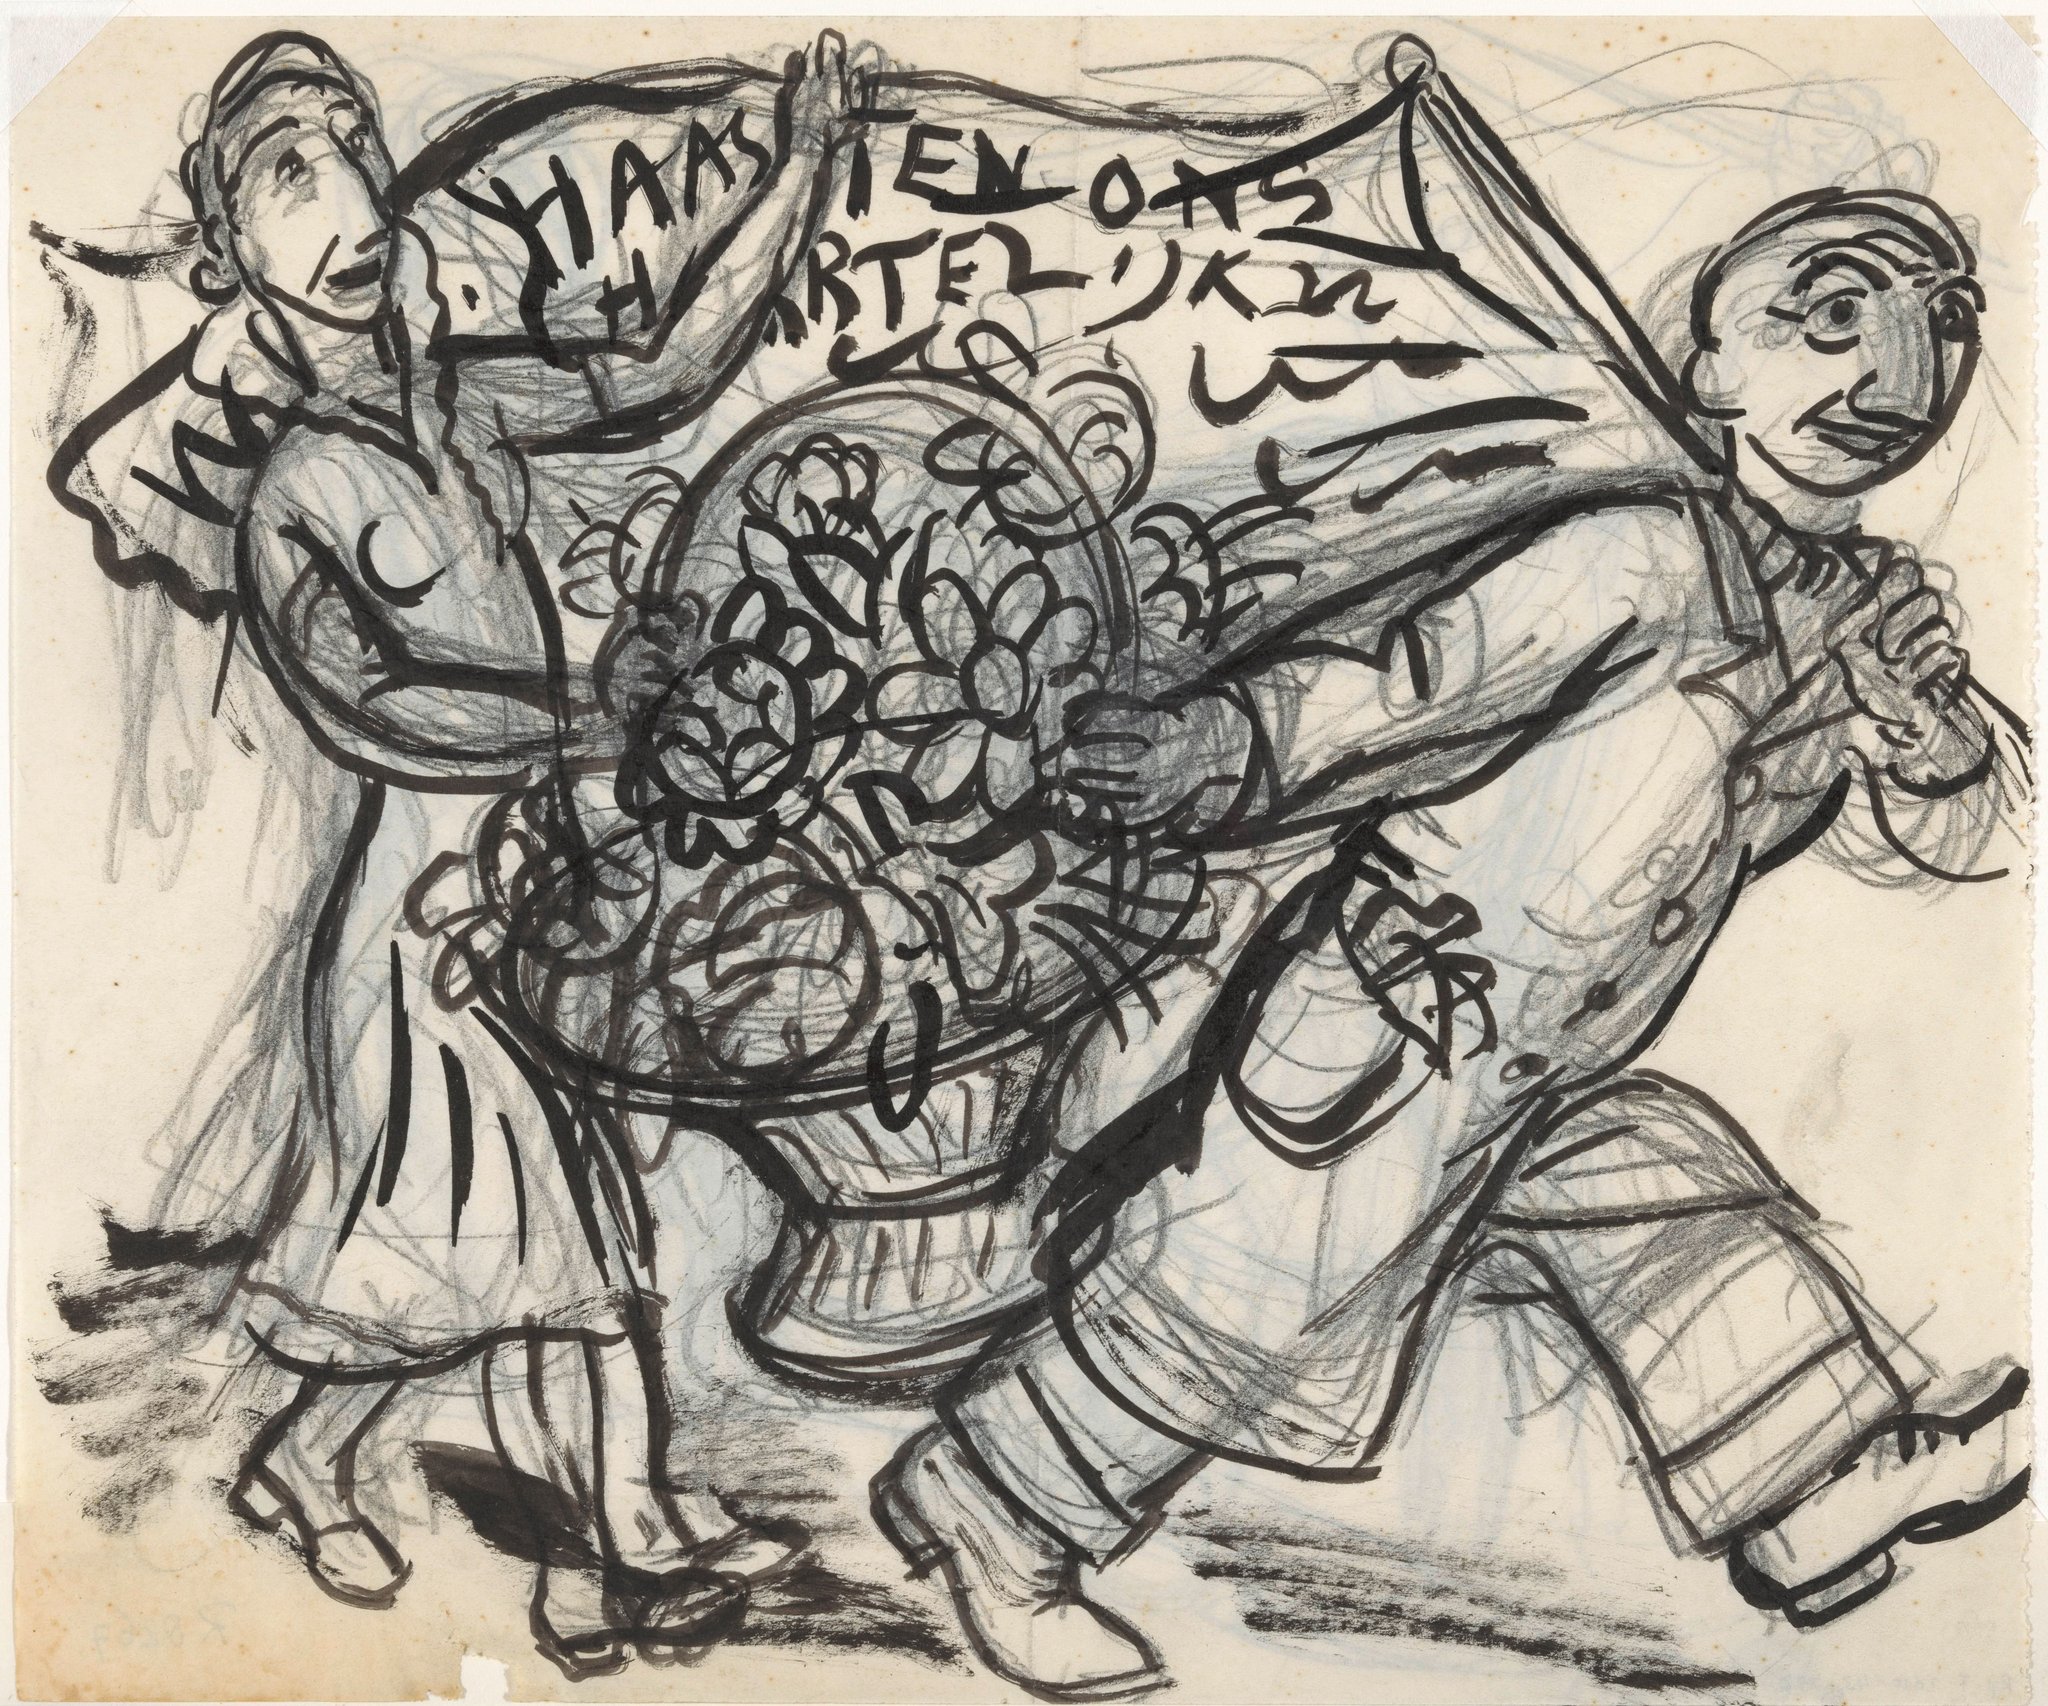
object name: greeting card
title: Leo Gestel en An Overtoom met bloemstuk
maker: leo gestel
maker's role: draughtsman, print maker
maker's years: 1881-1941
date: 1937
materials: ink, paper, pencil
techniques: pen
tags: print maker, draughtsman, leo gestel, amsterdam, painter, gerritje gestel-overtoom, flowers, adult woman, adult man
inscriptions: date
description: Vermoedelijk een ontwerp voor een wenskaart voor 1937, zie RP-T-2010-43-170 en RP-T-2010-43-172(R).